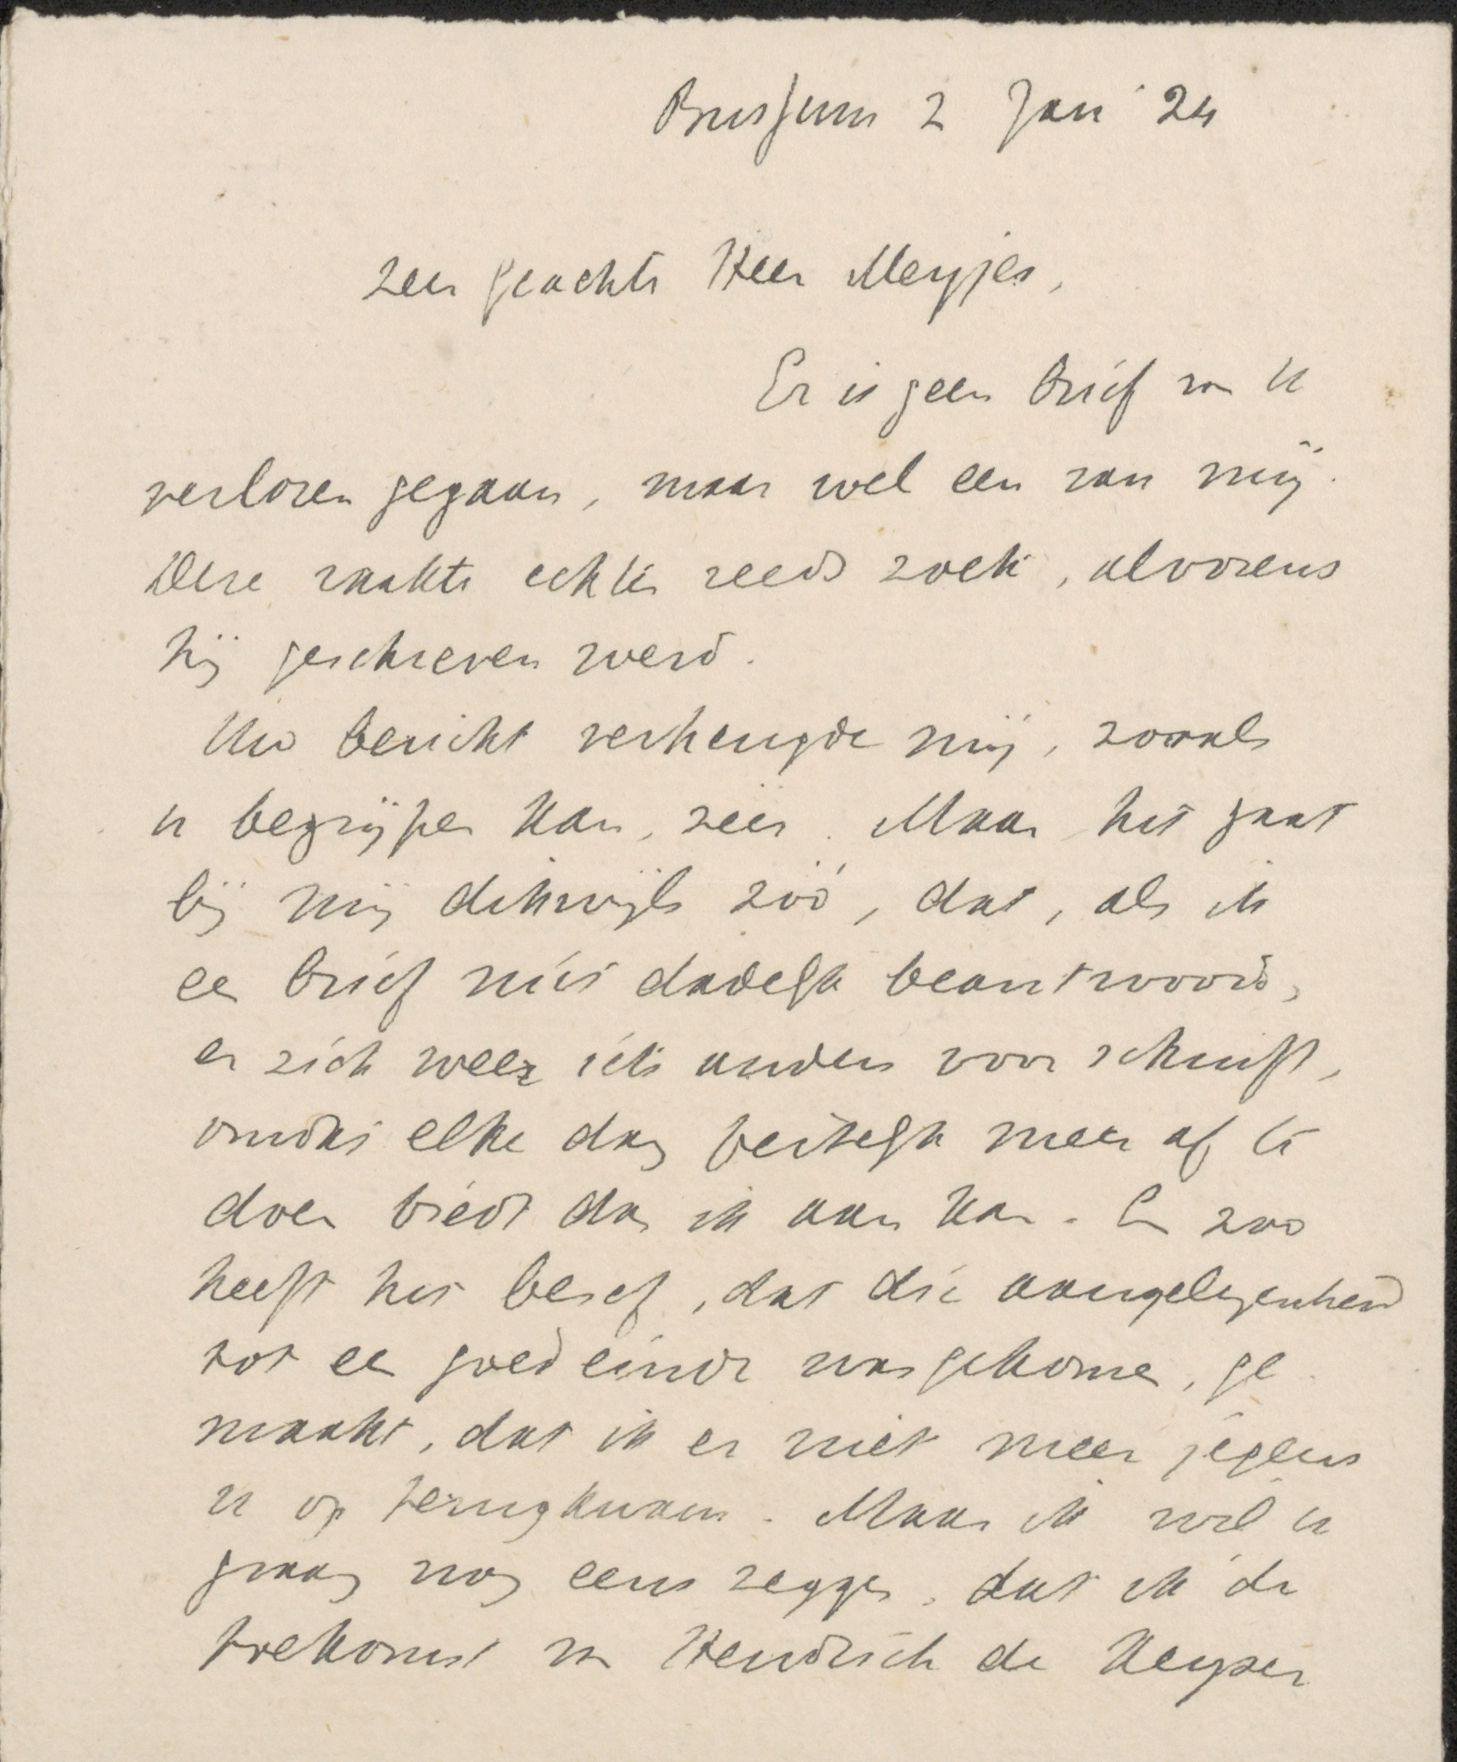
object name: letter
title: Brief aan F.E. Posthumus Meyjes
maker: jan veth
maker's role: designer, draughtsman, painter, print maker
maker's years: 1864-1925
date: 1924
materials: ink, paper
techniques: pen, writing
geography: bussum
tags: f.e. posthumus meyjes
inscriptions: collector's mark: ‘RPK’